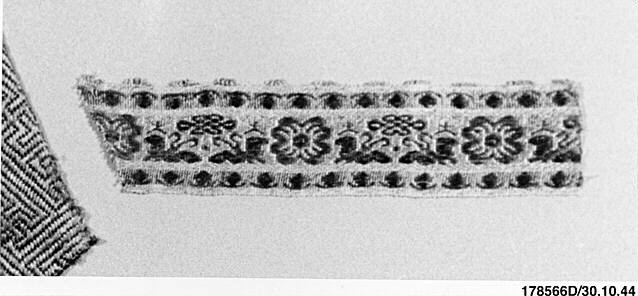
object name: ribbon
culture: chinese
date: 1801-1900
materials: silk